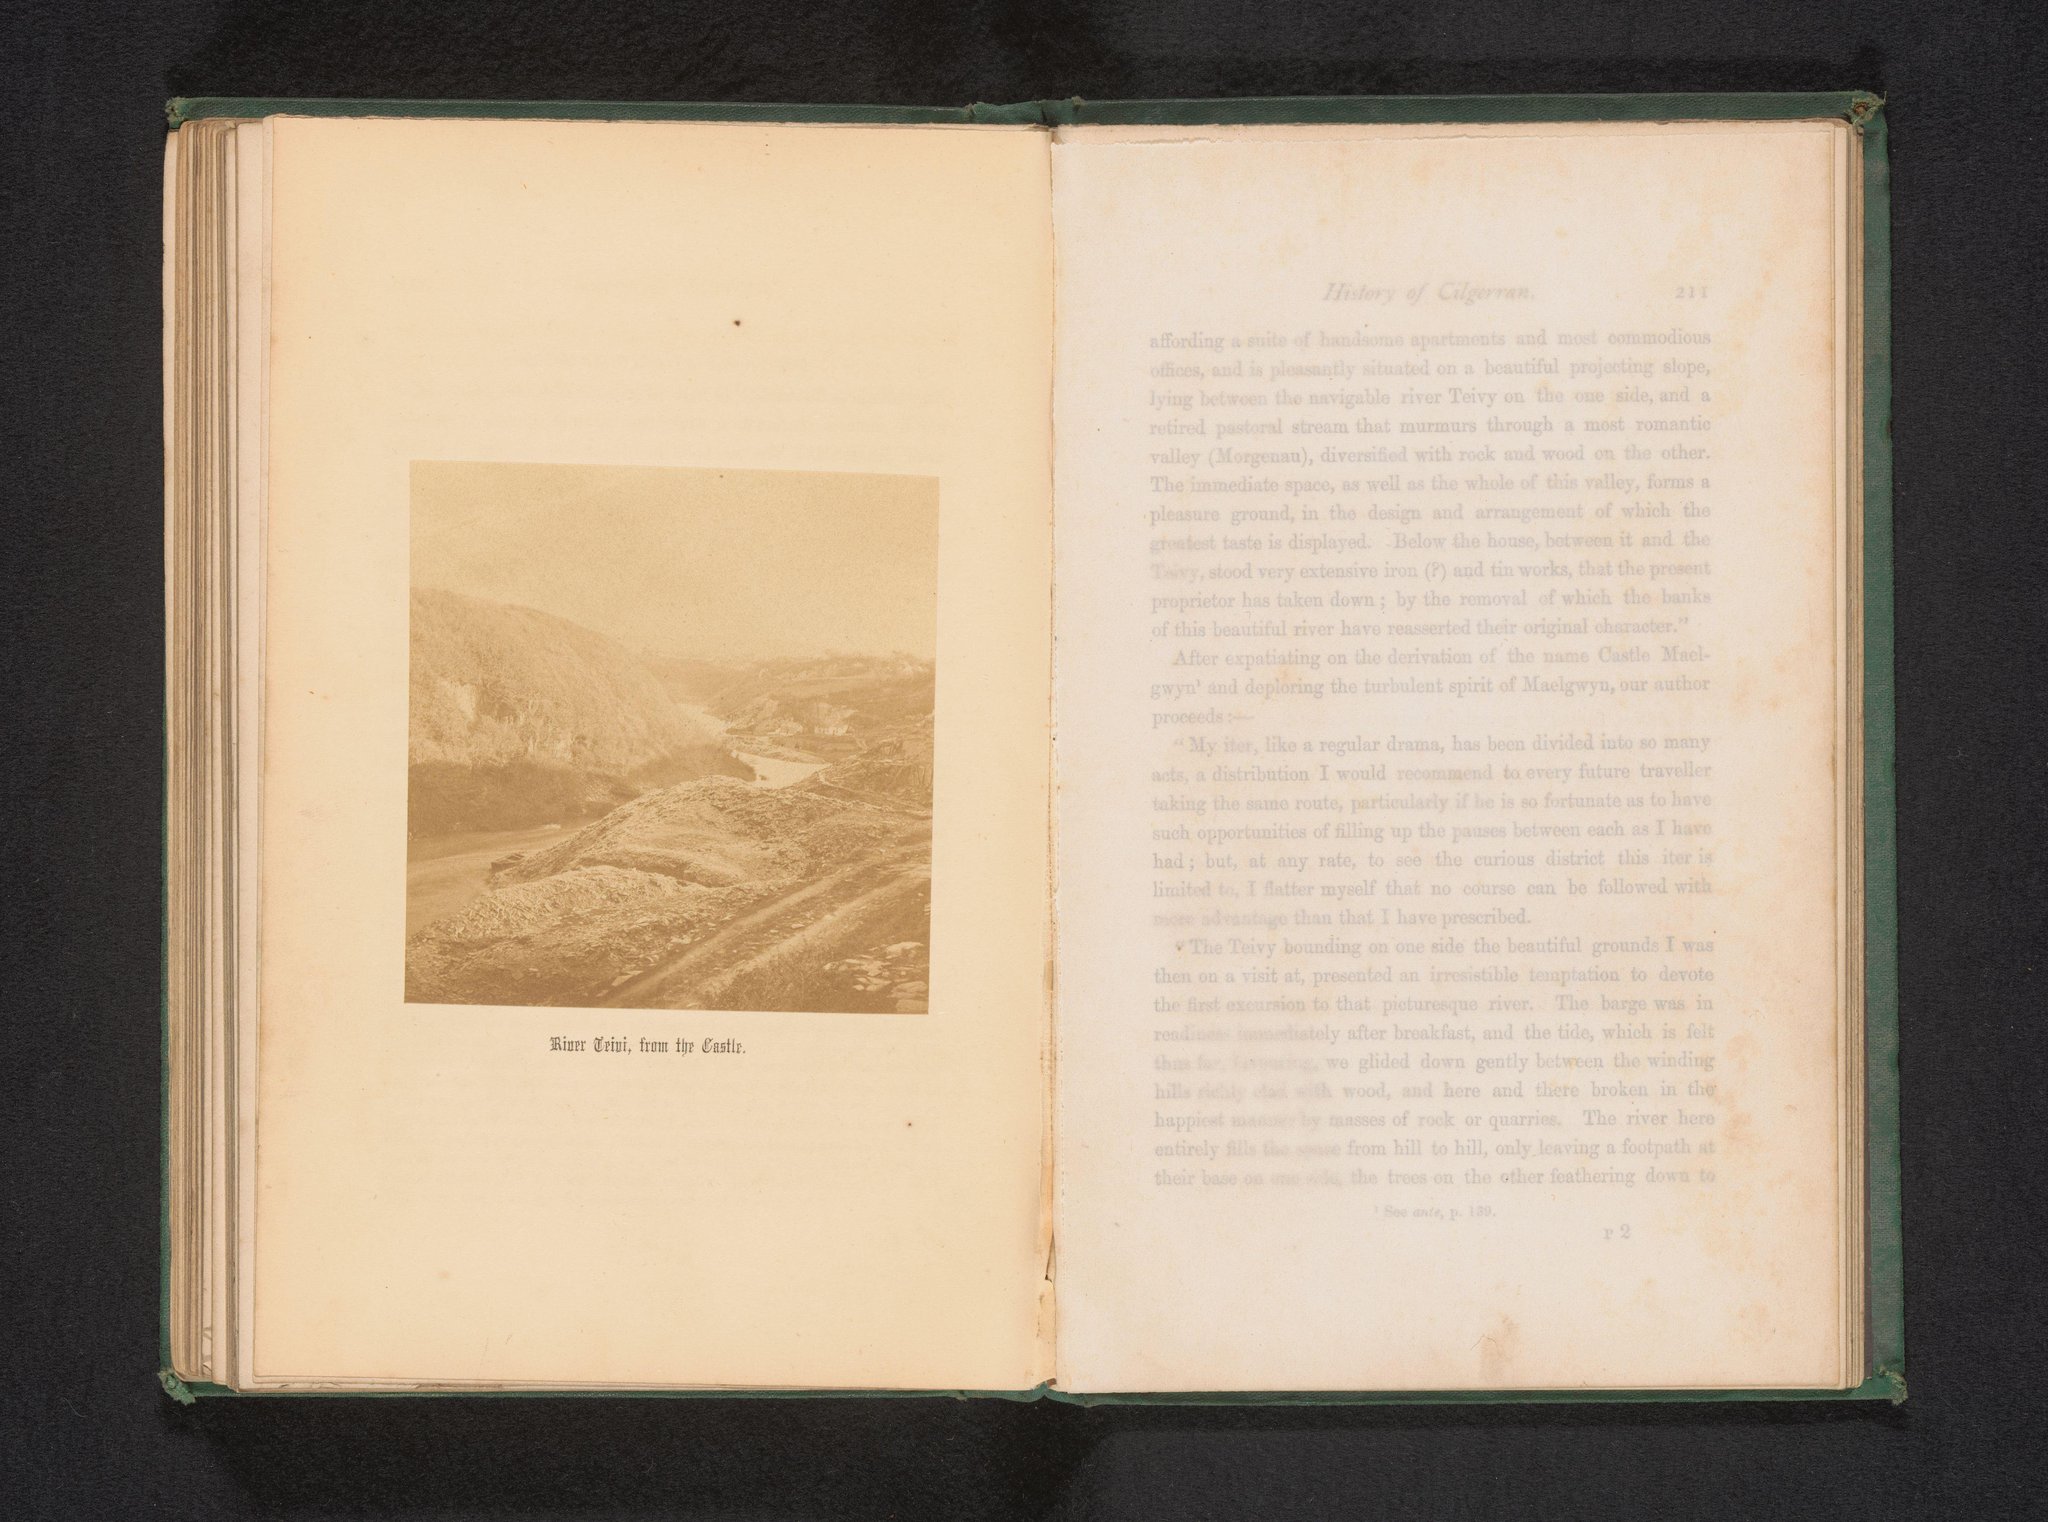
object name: photograph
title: Gezicht op de rivier Teifi in Pembrokeshire, Wales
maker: charles allen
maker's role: fotograaf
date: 1862-1867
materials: photographic support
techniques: albumen print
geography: teifi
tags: low hill country, river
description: Foto tegenover pagina 211, achter semi-transparante omslag.